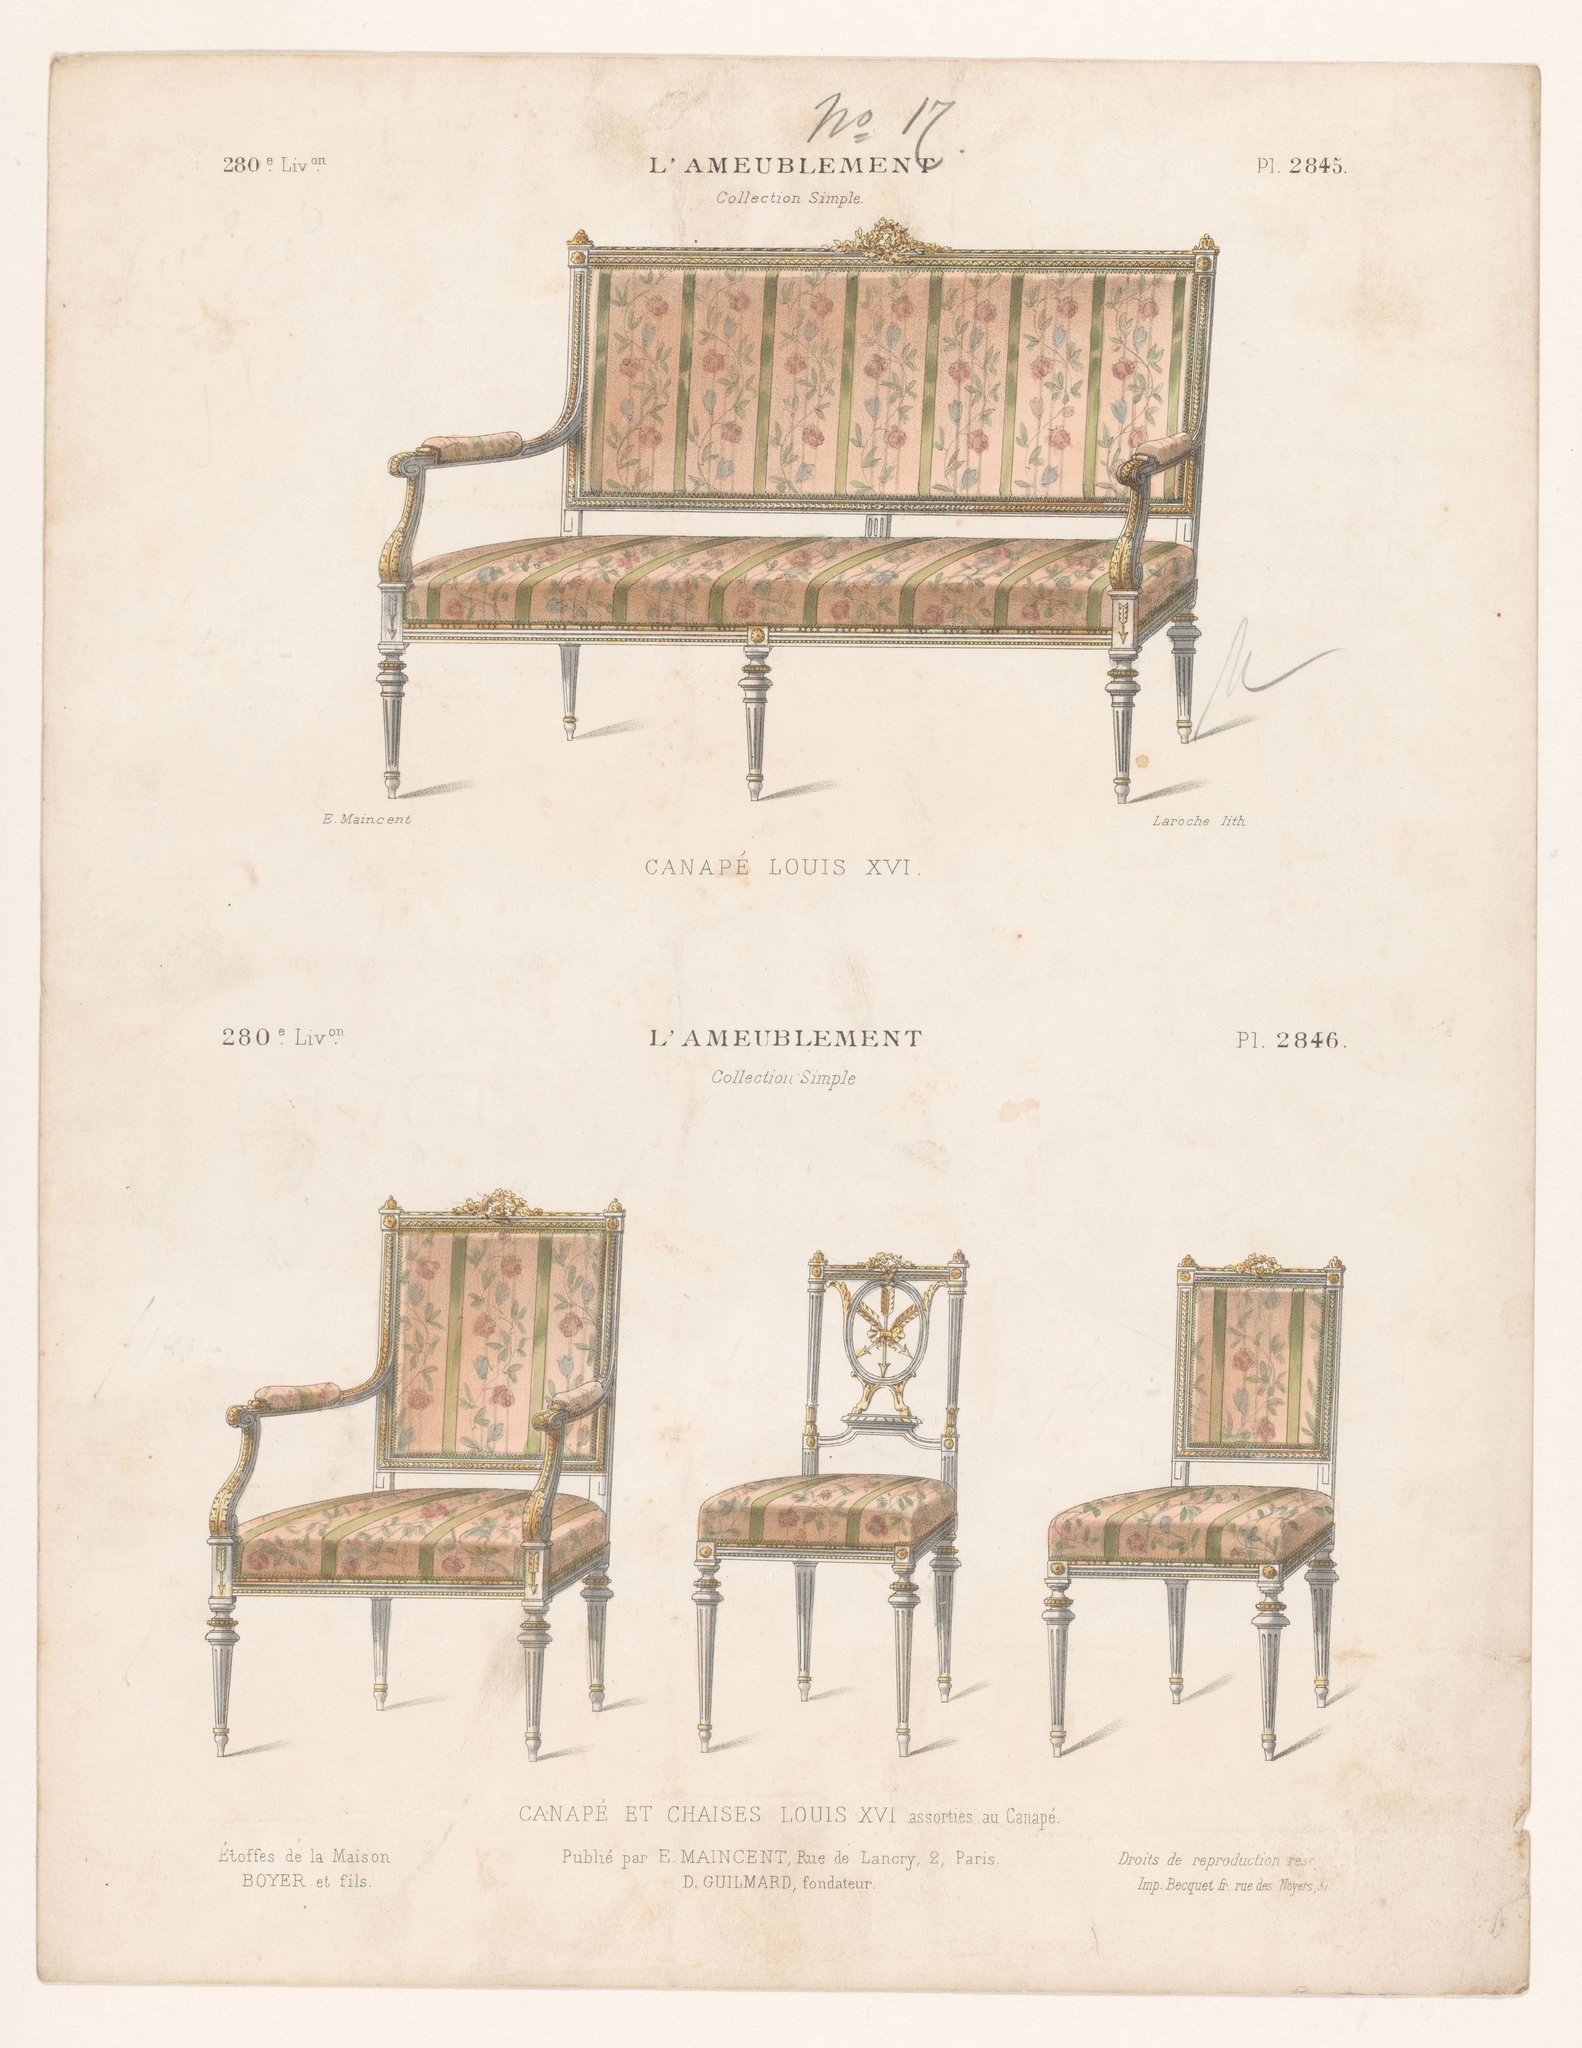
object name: print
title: L'ameublement / Collection simple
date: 1885-1895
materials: paper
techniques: hand coloring, lithograph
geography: paris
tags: shelves, rack, sideboard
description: Een canapé en drie stoelen in de Lodewijk XVI-stijl. Prent uit 280e Livraison.